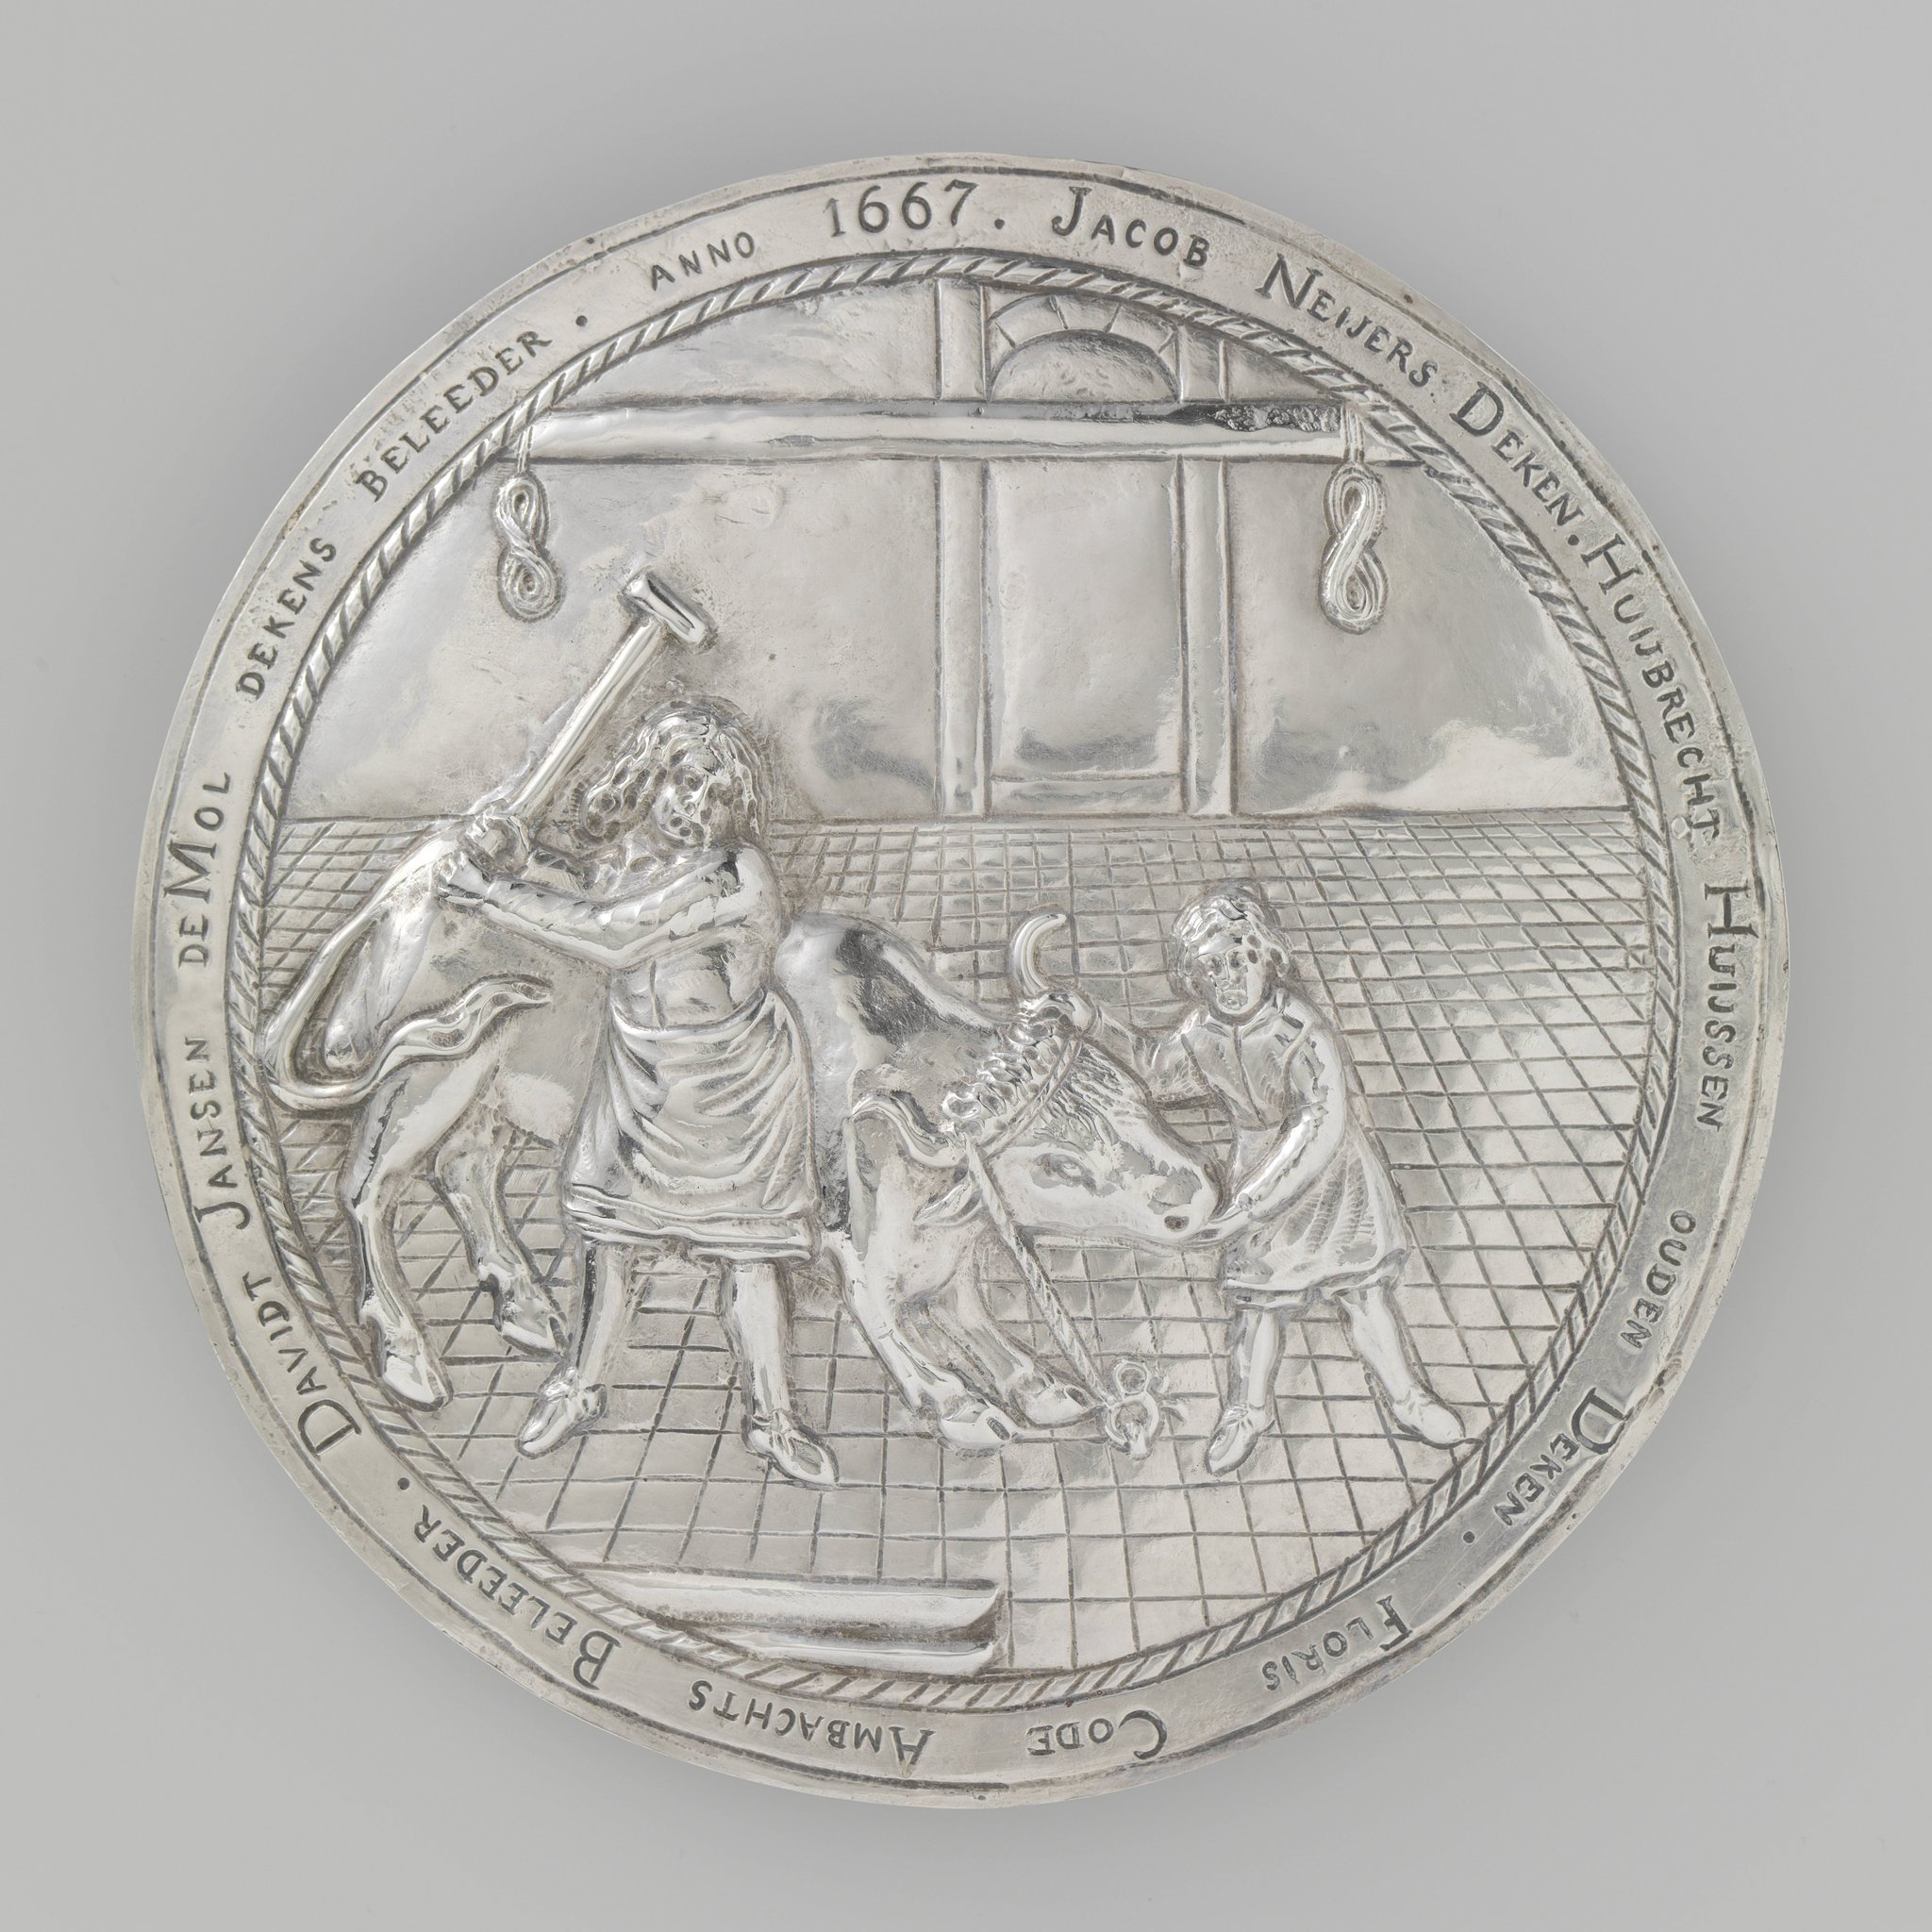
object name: gildeschild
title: Gildeschild van gedreven zilver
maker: Anonymous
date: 1667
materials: silver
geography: middelburg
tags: butcher, slaughterman, ox, middelburg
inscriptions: date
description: Rond schild van gedreven zilver, van een slachters-Gilde. Met een voorstelling van een aan een ring gebonden os, door een jongen vastgehouden, terwijl de slachter de dodelijk slag toebrengt.